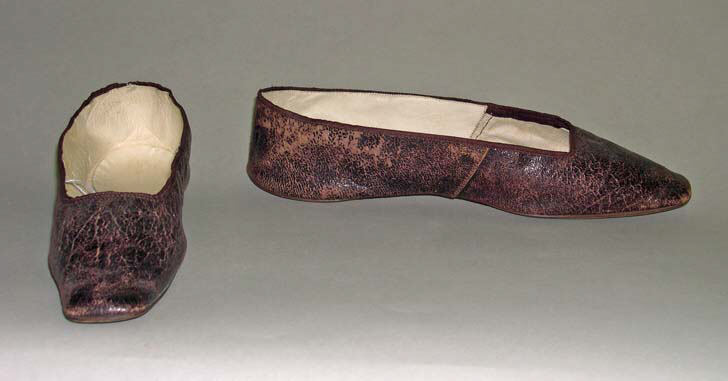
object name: shoe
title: Shoes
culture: italian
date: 1840-1849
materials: leather